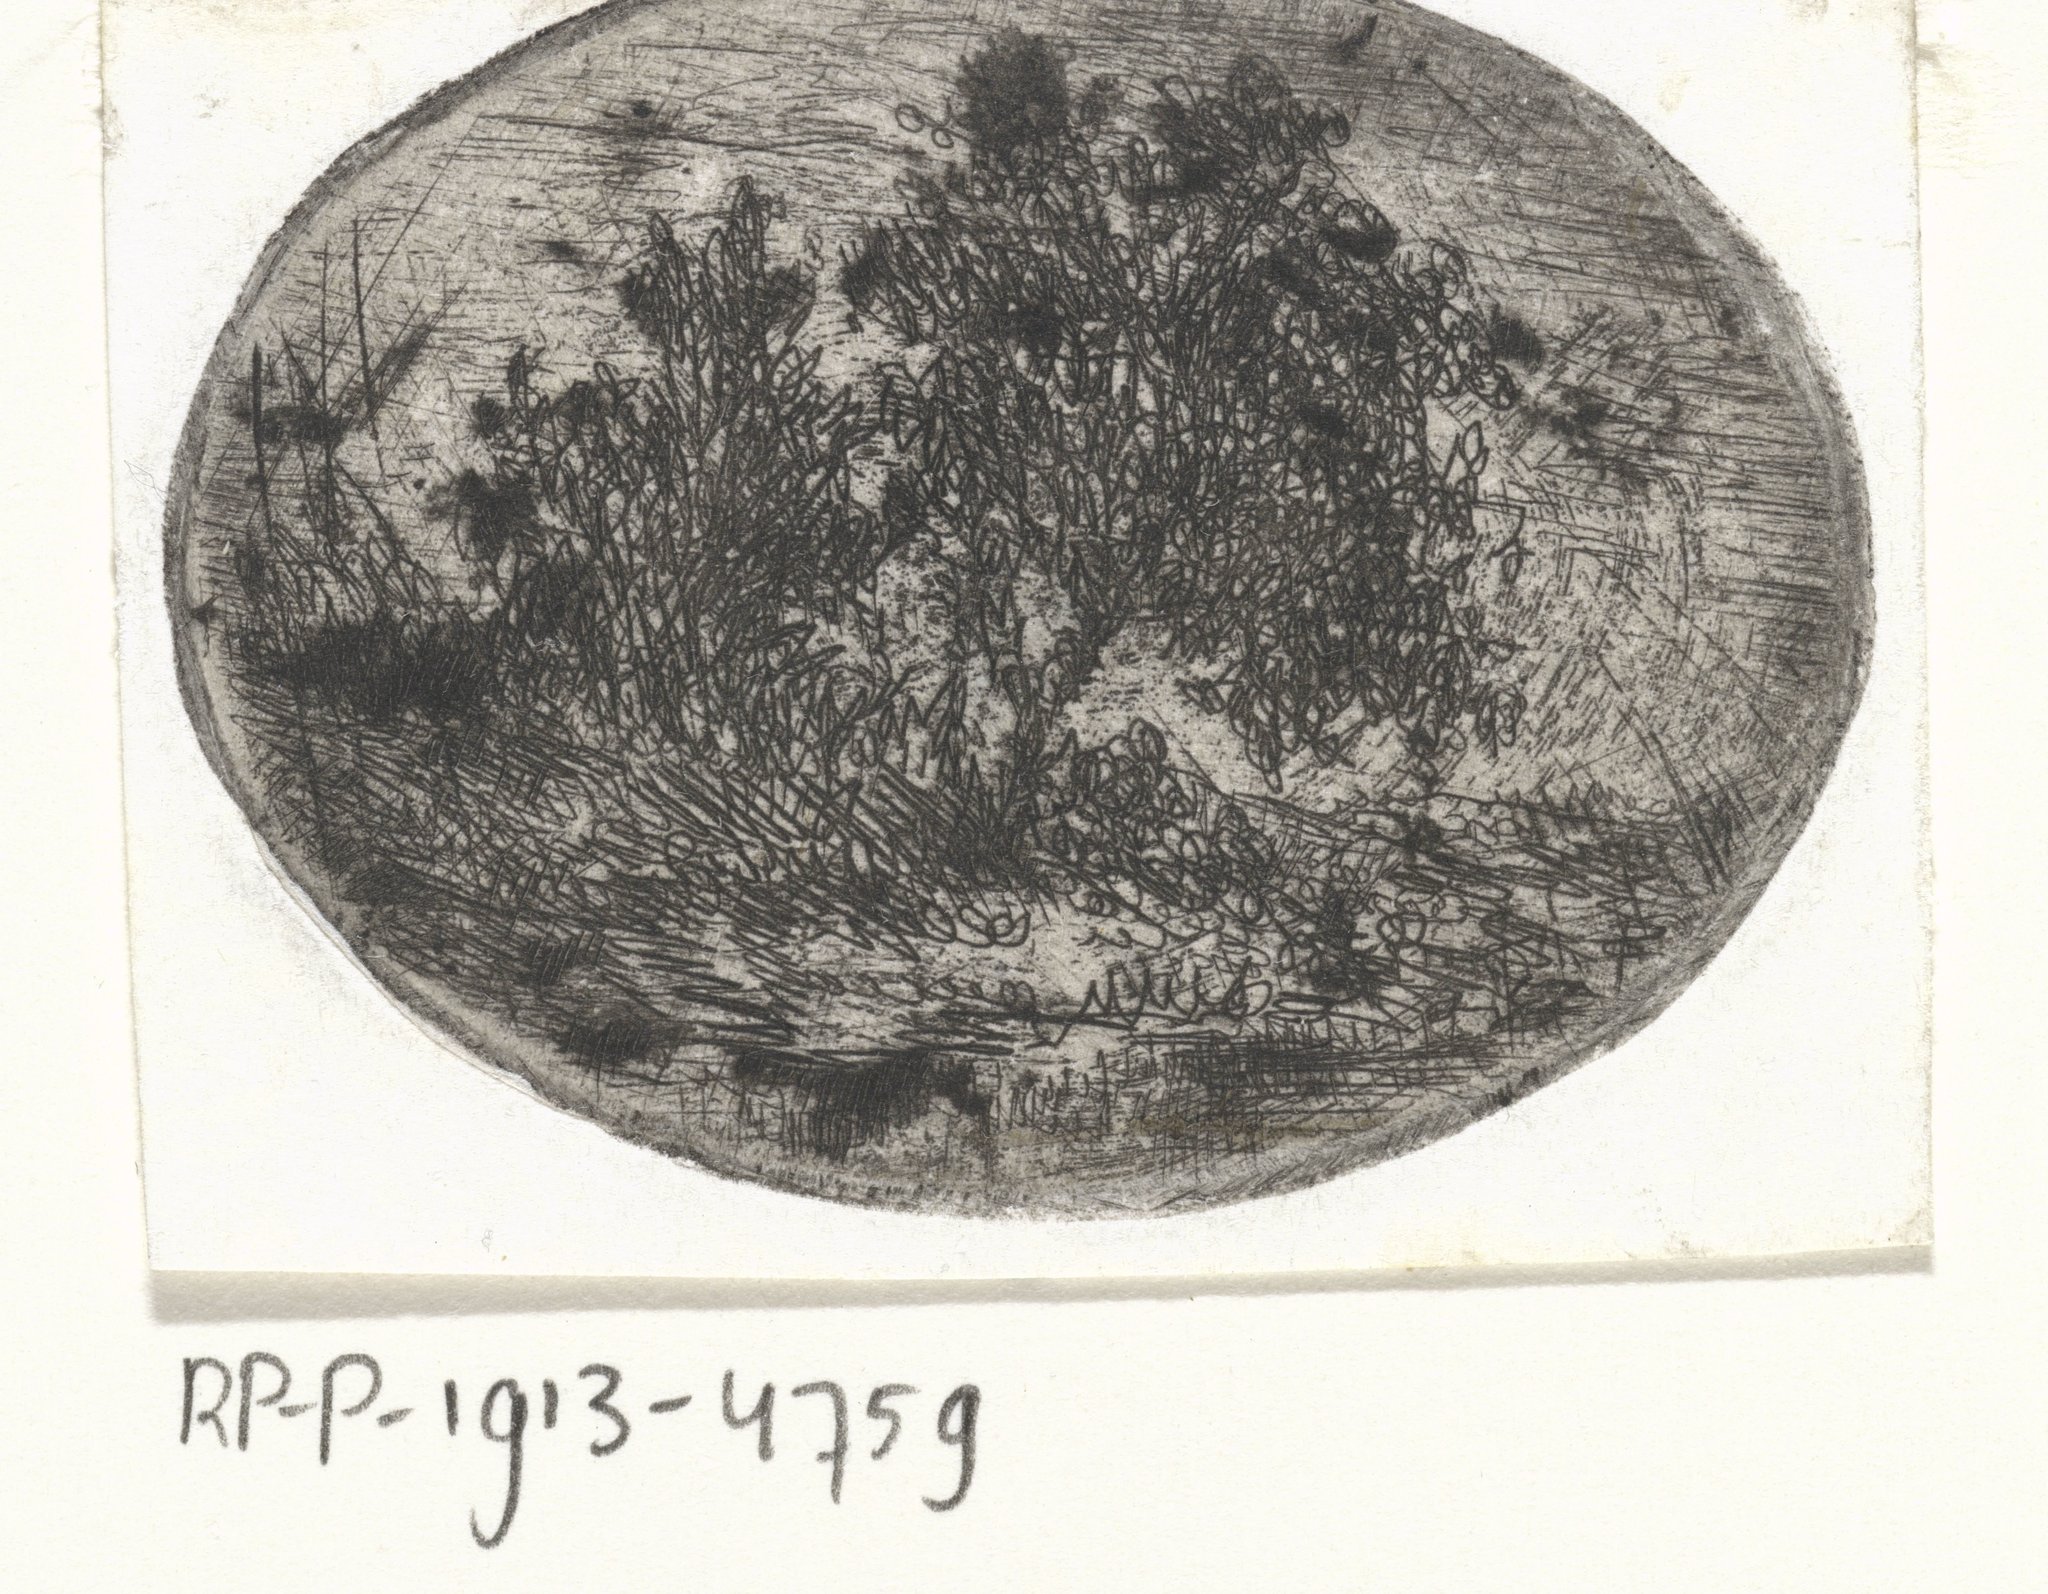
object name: print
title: Landschap met boomgroep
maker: arnoud schaepkens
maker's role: print maker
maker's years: 1816-1904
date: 1831-1904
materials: paper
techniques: drypoint, etching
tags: trees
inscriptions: collector's mark: Lugt 2228